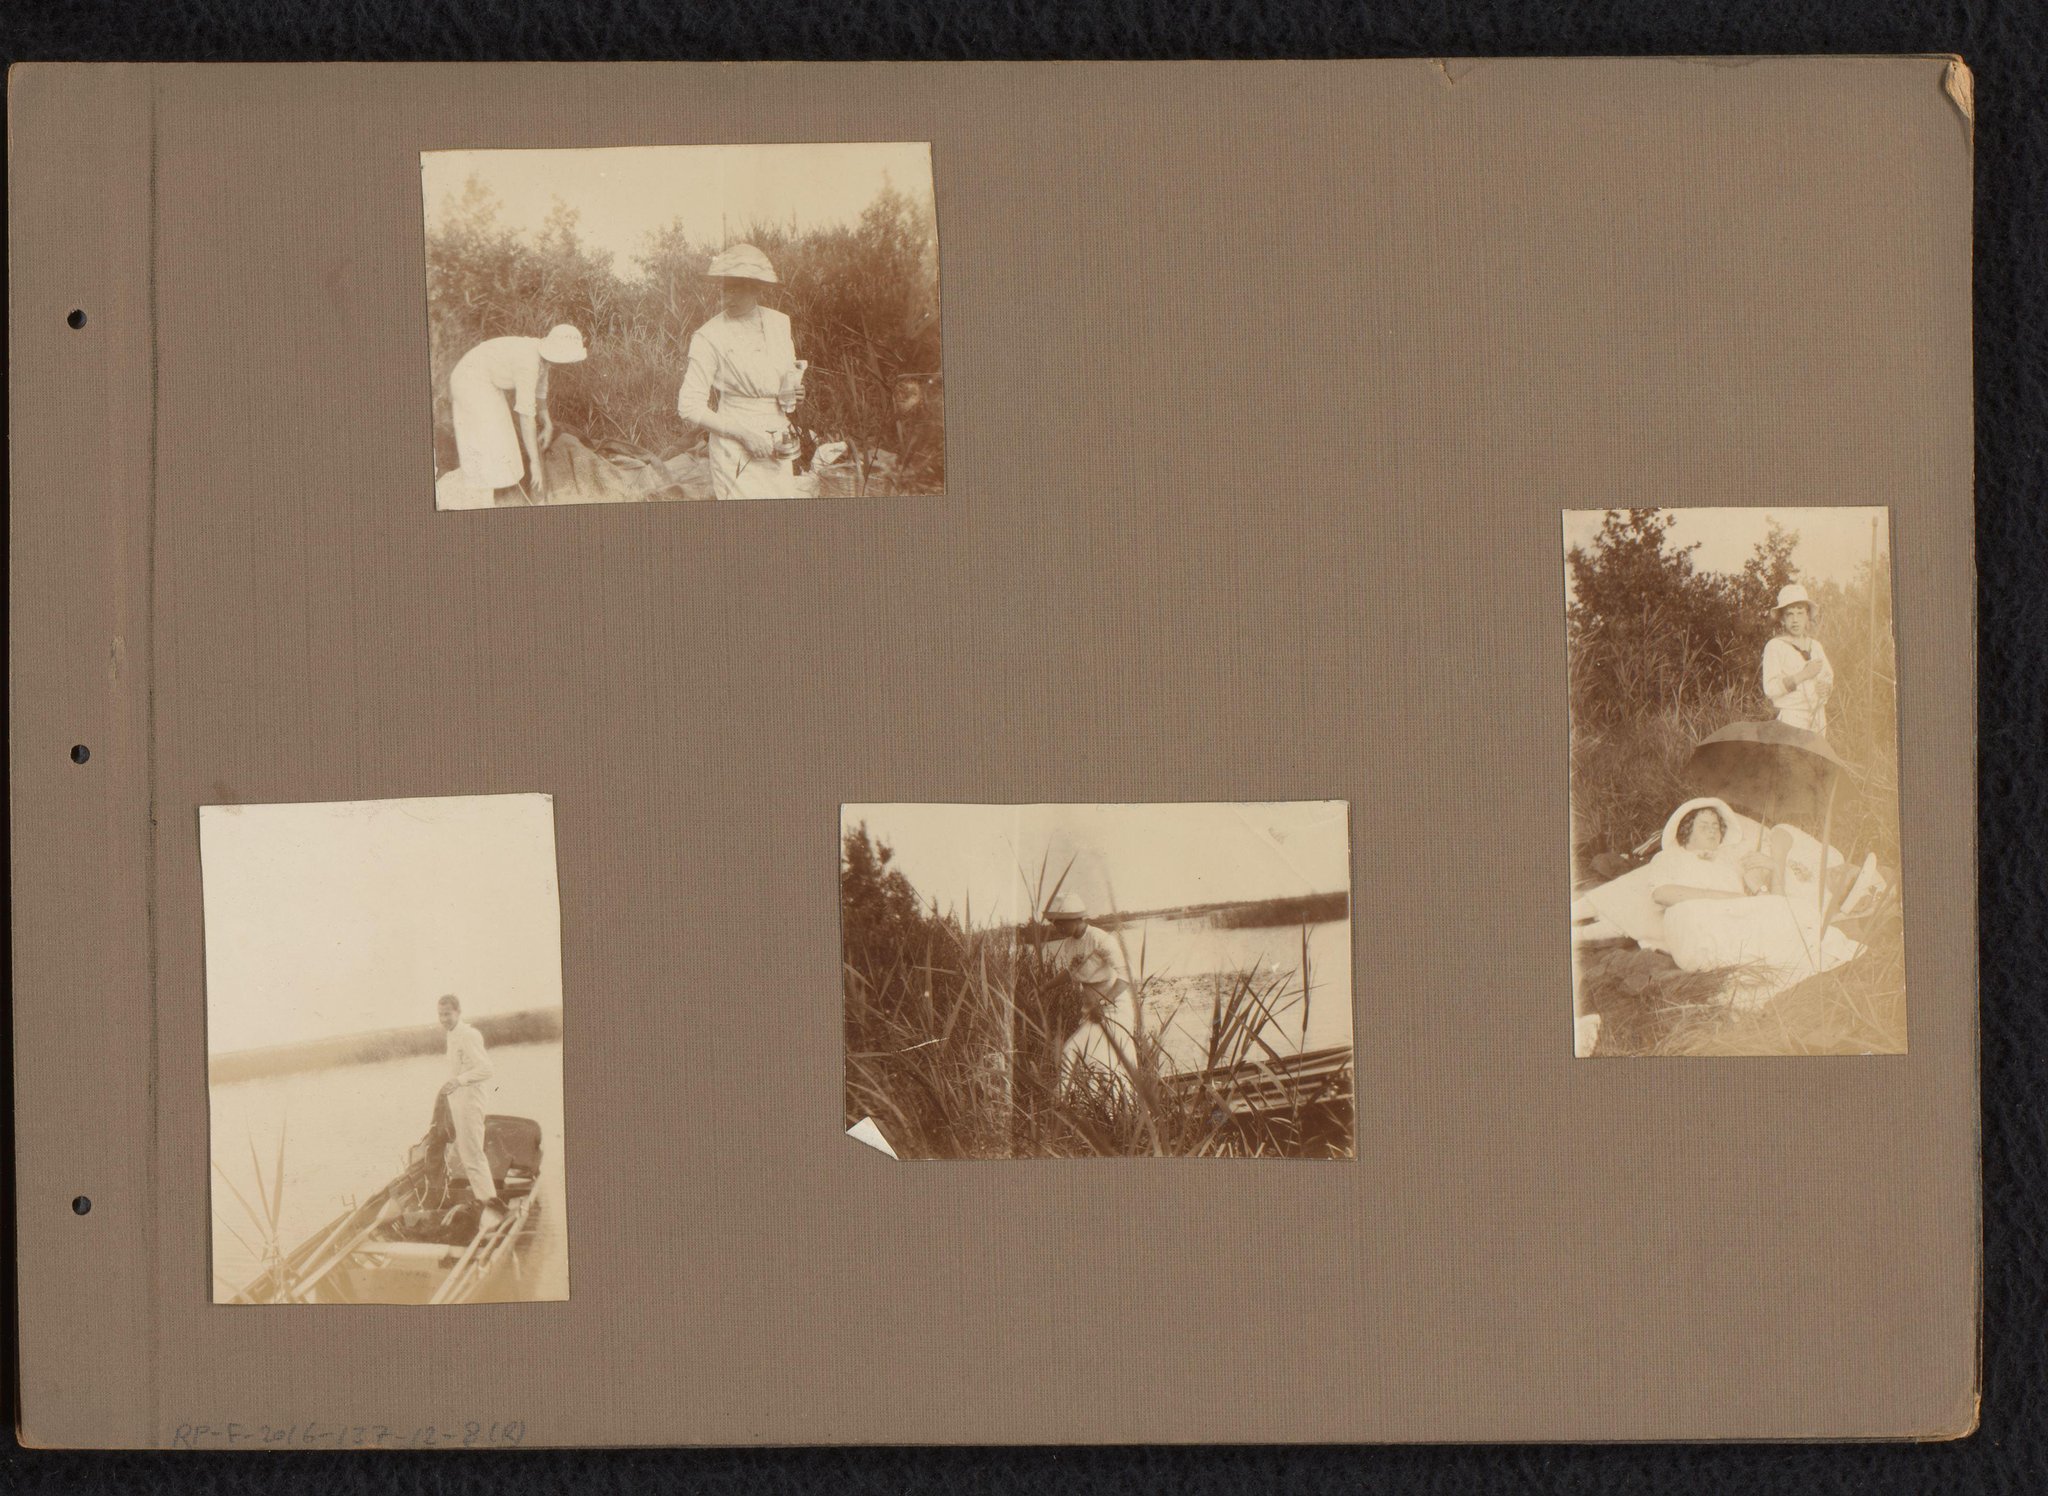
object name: photograph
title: Gezin Onnen tijdens een vaartocht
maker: carolina frederika onnen (lien/loen)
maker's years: 1896-1983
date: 1911-1912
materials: paper, cardboard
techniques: collodion silver print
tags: rowing-boat, canoe, etc., family life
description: Deze foto's zijn onderdeel van een album.